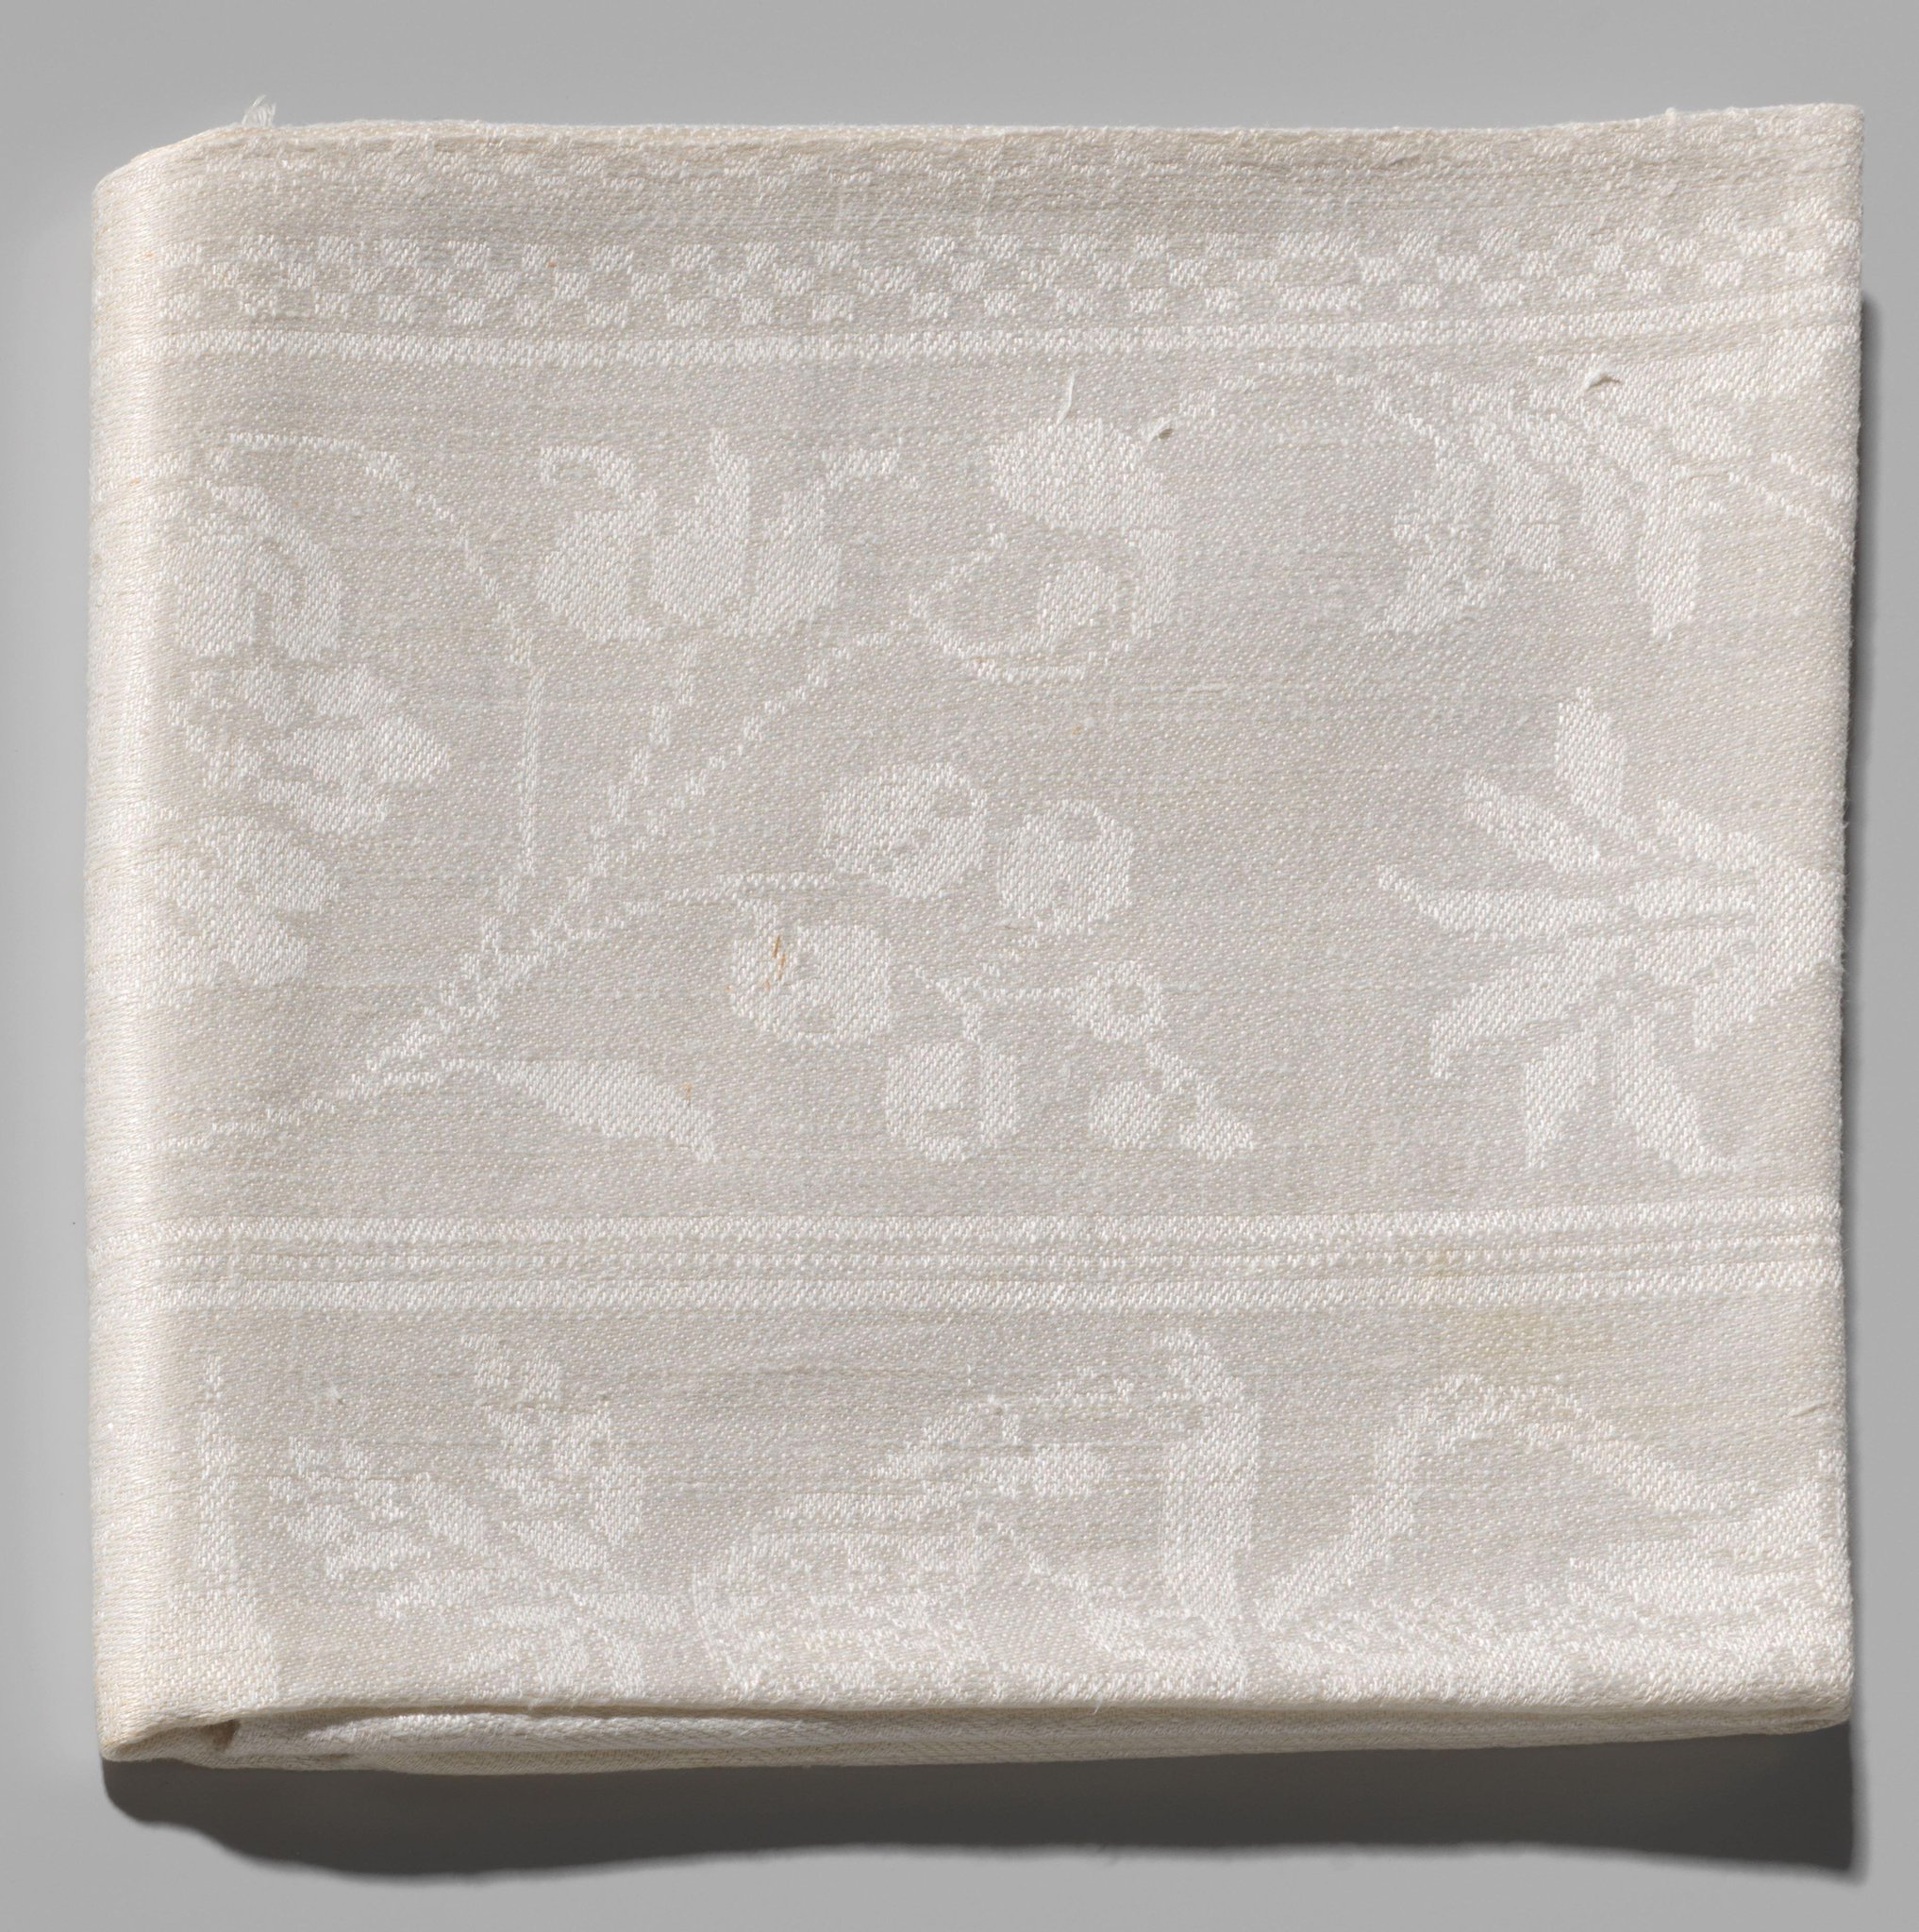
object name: napkin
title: Servet met de vier deugden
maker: Anonymous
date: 1730-1750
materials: linen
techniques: damask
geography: germany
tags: the four cardinal virtues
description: Servet van linnendamast met de vier deugden. Middenveld: het asymmetrisch patroon vertoont van onder naar boven vijf taferelen: 1 Geloof, voorgesteld door een naar links gekeerde staande vrouwenfiguur, die in de ene hand een kruis vasthoudt en in de andere een kelk in stralenkrans toont. Opschrift: GLAUBE. 2 Geduld, voorgesteld door een zittende vrouw die een schaap scheert. Opschrift: GEDULT. 3. Hoop, voorgesteld door een staande vrouw, die de armen langs de zijden houdt met anker in de ene hand en nimbus (?) in de andere. Links van haar vaart een schip, op welks zeil een kruis. Opschrift: HOFFNUNG. 4 Liefde, als zittende vrouw, op wie van rechts een kind met bloem komt toelopen. Rechts een dennenboom in kuip. Opschrift: LIEBE. 5. Aanzet van opnieuw tafereel 1. Staande randen± lopende rank, waaraan gevarieerde pioenachtige bloemen+ daarbuiten: blokkenrand.